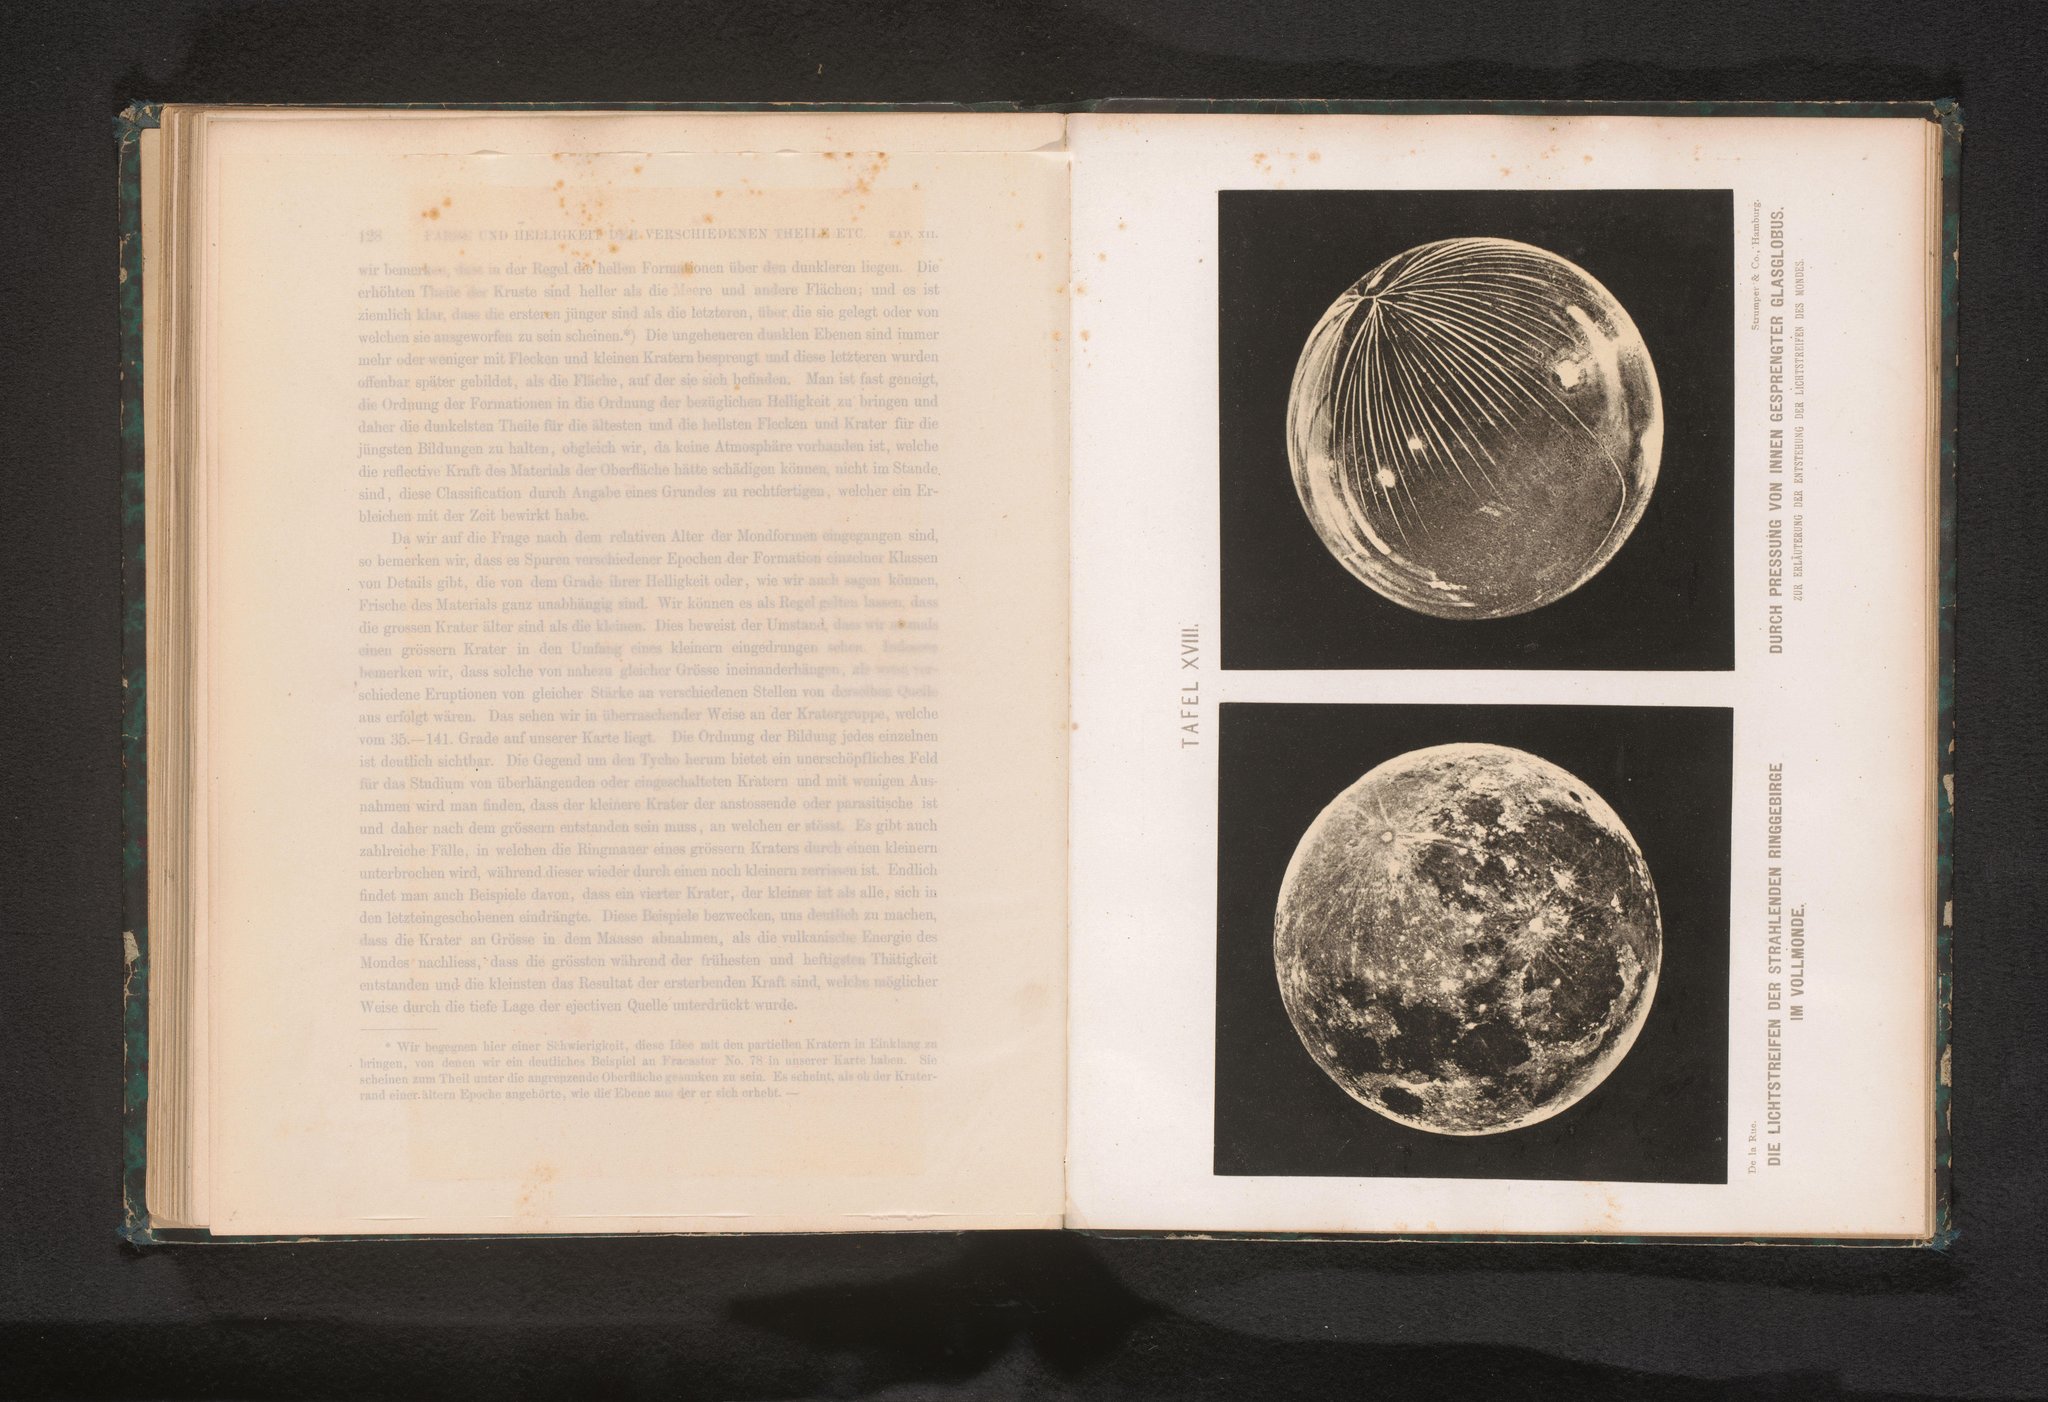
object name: photomechanical print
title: Durch pressung von innen gesprengter Glasglobus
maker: warren de la rue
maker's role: astronoom, fotograaf, scheikundige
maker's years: 1815-1889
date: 1863-1873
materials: paper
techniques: photograph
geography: hamburg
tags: surface of the moon, sphere, globe ~ stereometry, moon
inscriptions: number: ‘Tafel XVIII.’